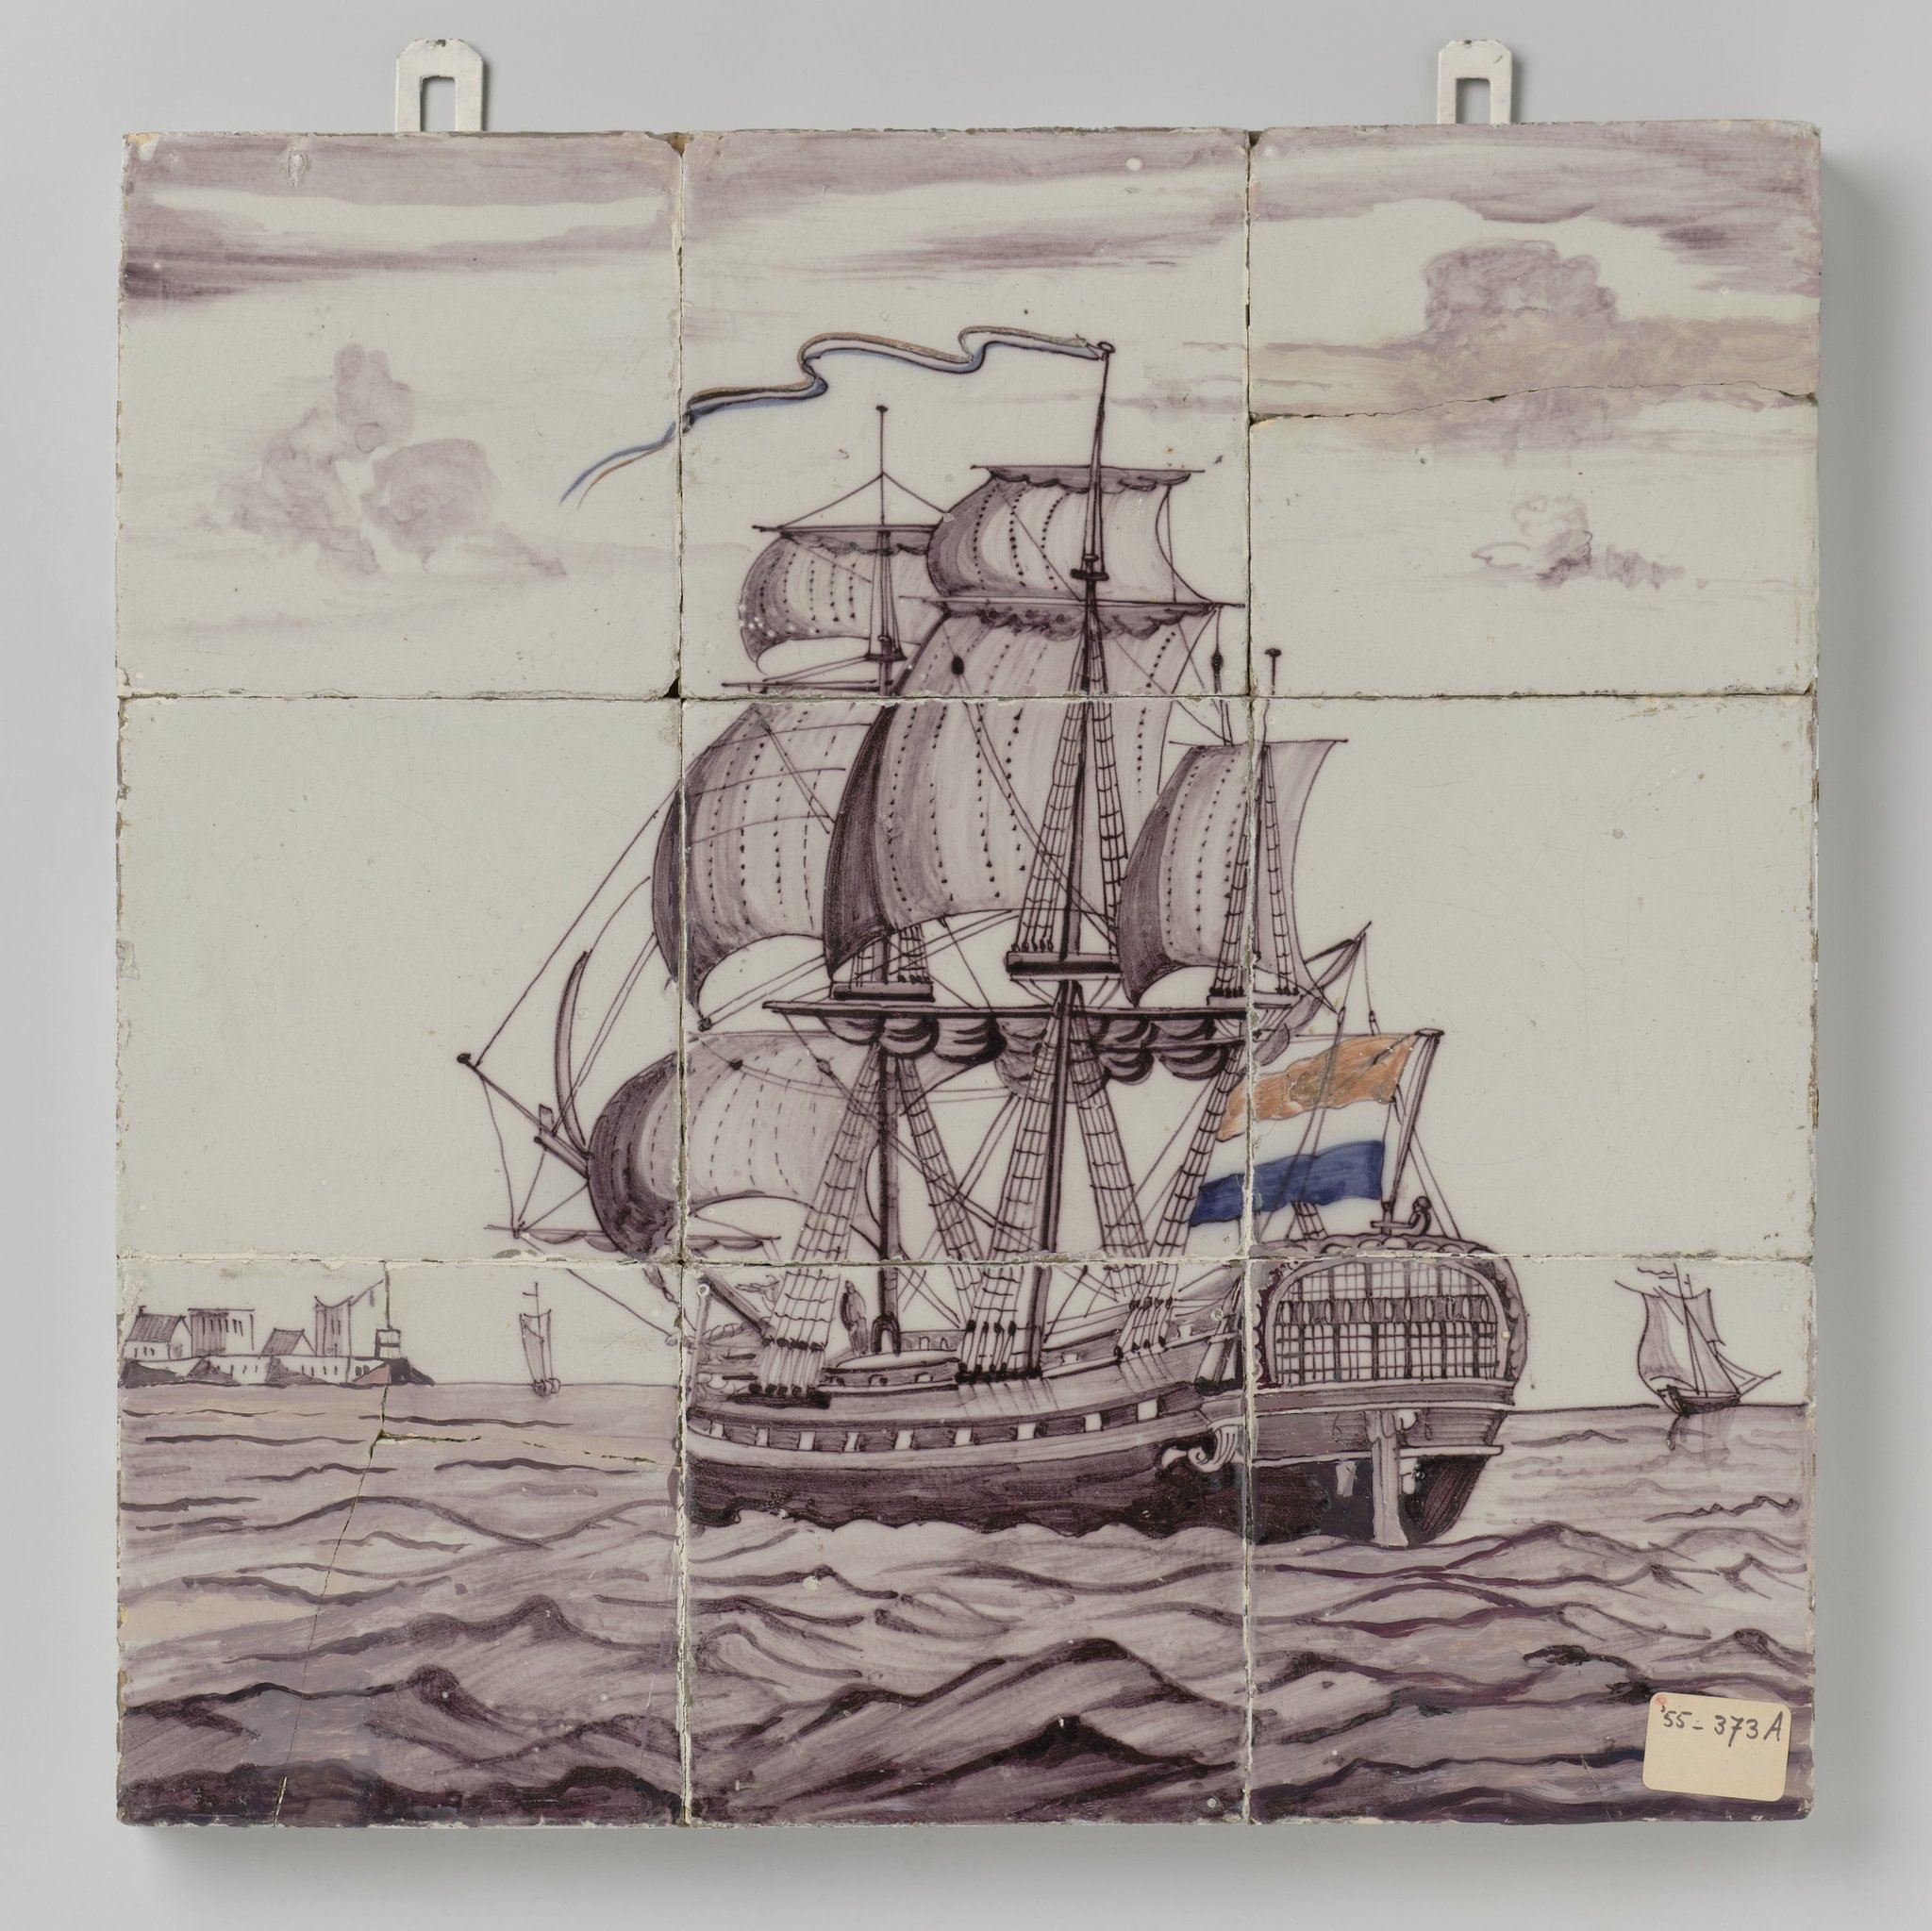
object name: tile tableau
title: Tegeltableau met driemaster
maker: Anonymous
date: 1780-1820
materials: earthenware, glaze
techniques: maiolica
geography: netherlands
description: Tegeltableau van negen tegels (3 x 3) met een paars geschilderde driemaster met de Nederlandse vlag. Links op de achtergrond, een stadsgezicht en rechts een zeilschip.